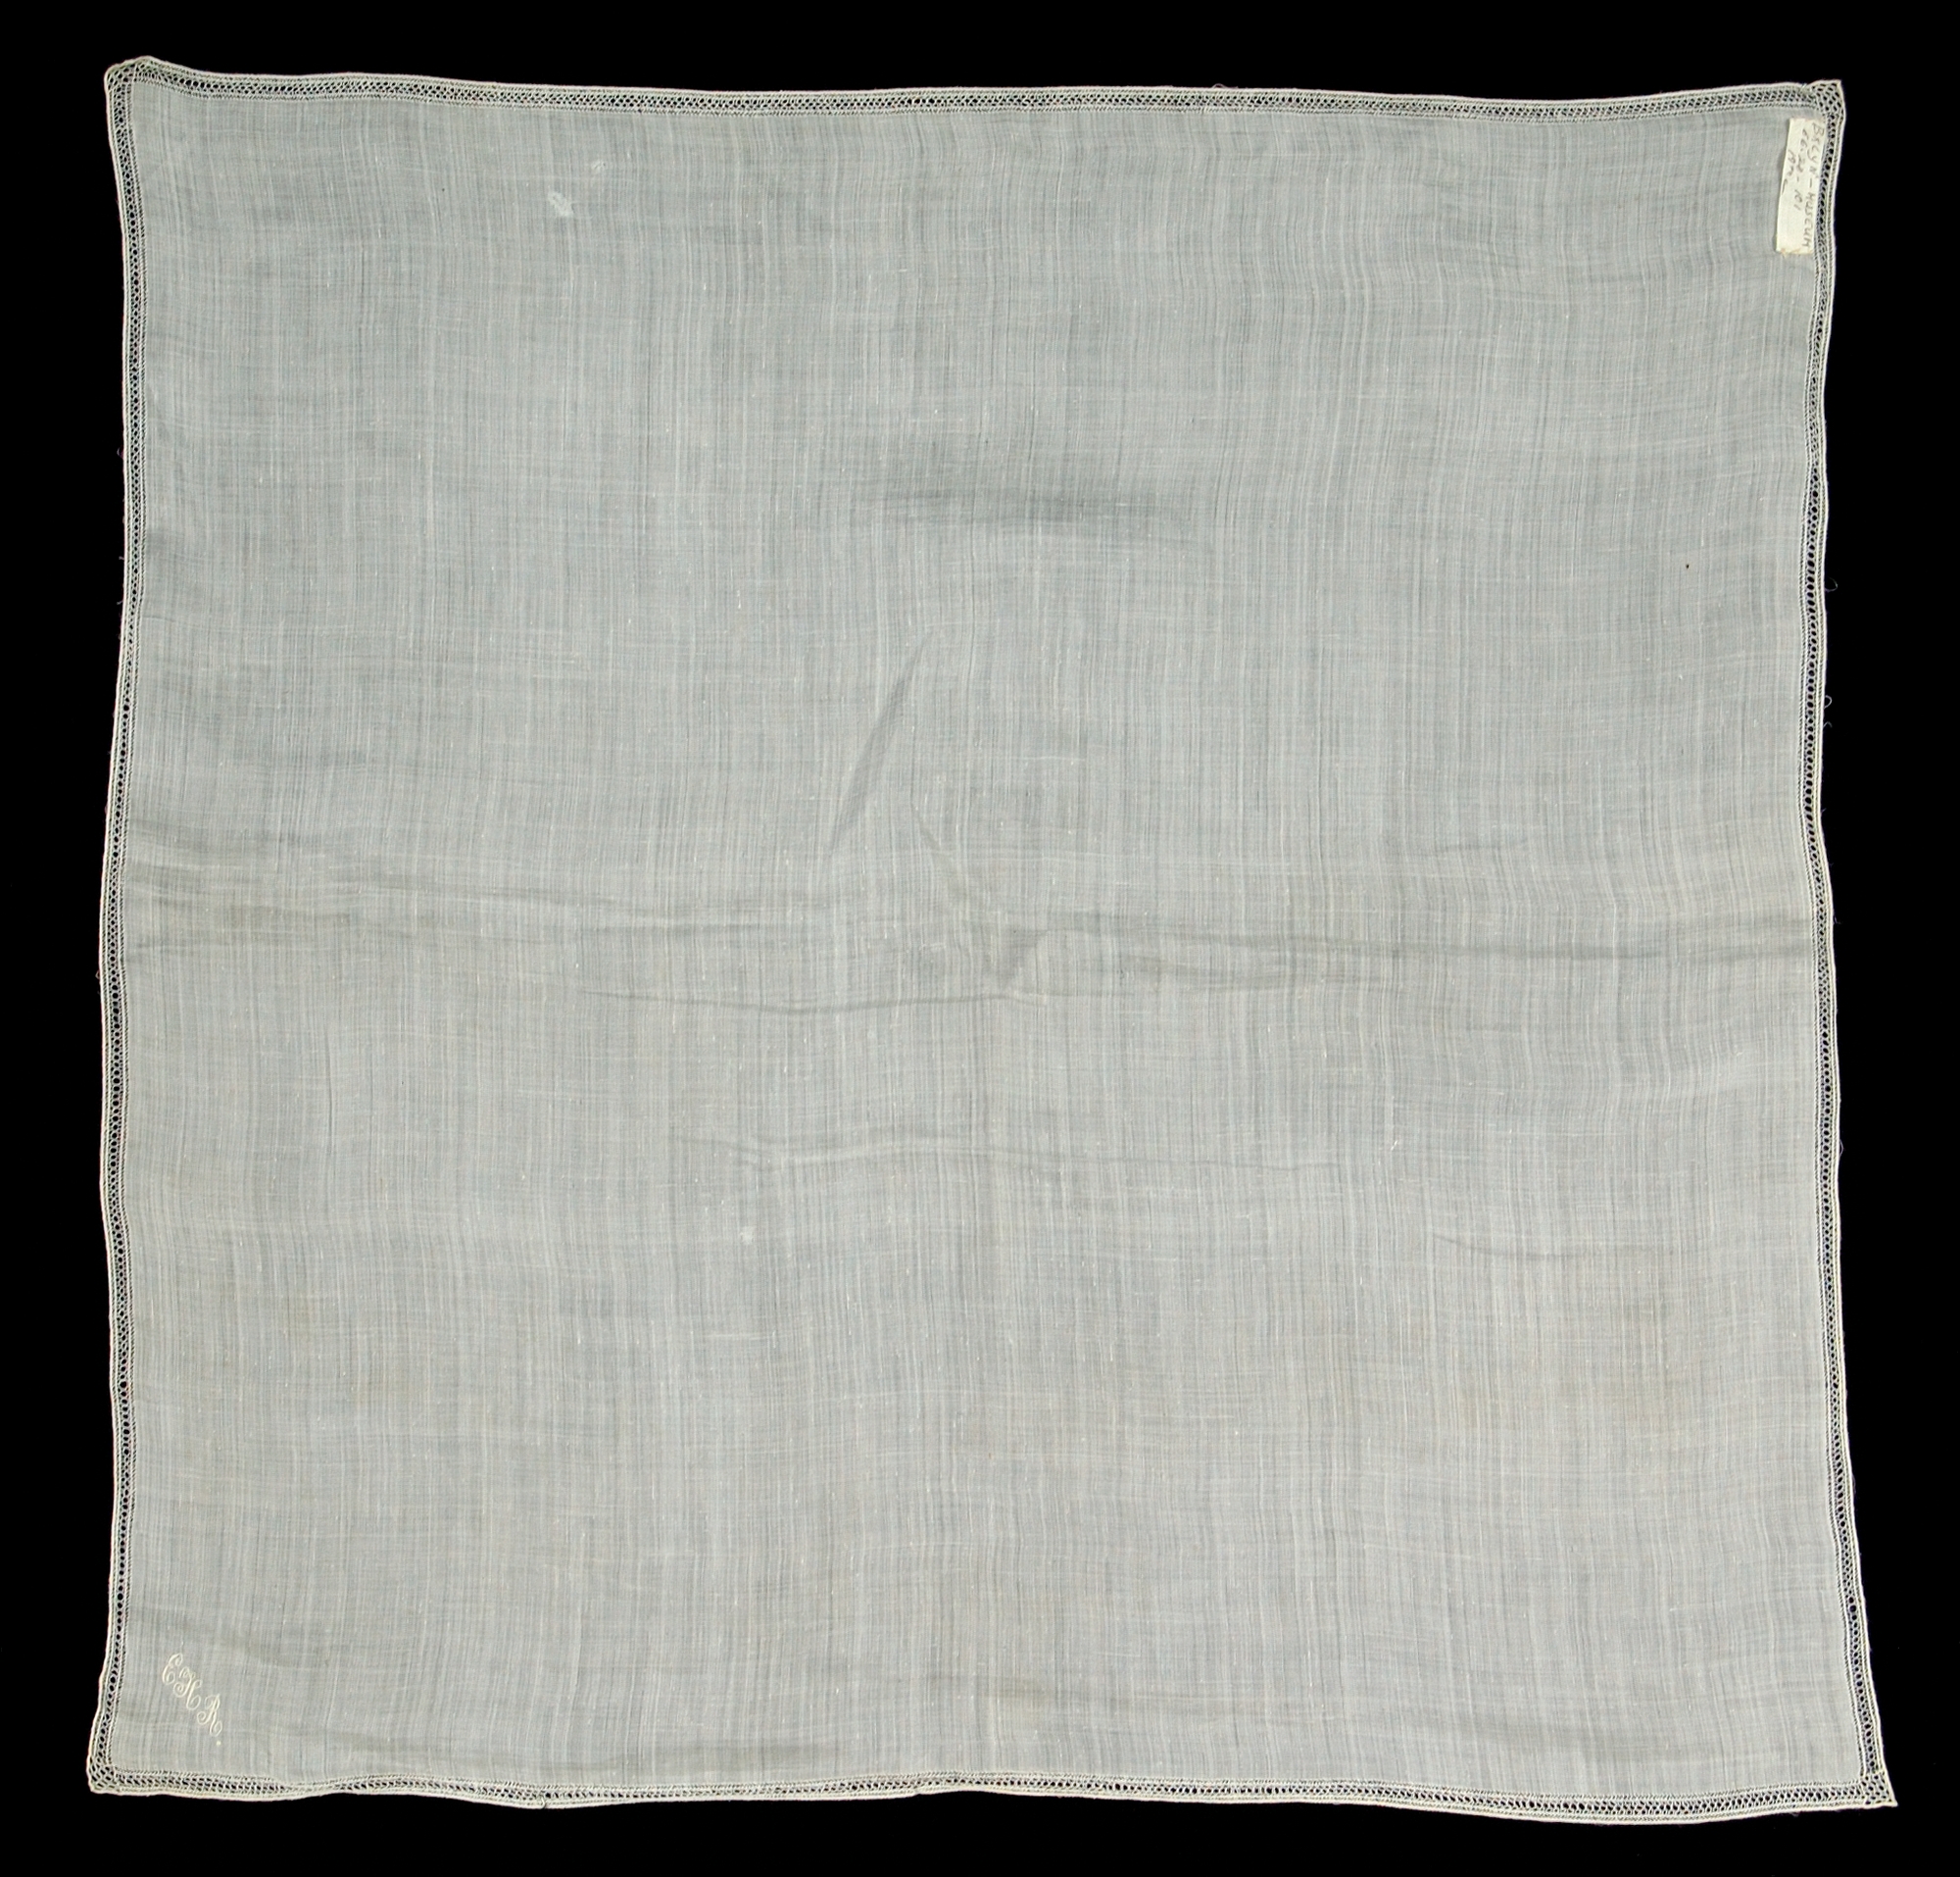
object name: handkerchief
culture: american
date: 1825-1850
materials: linen